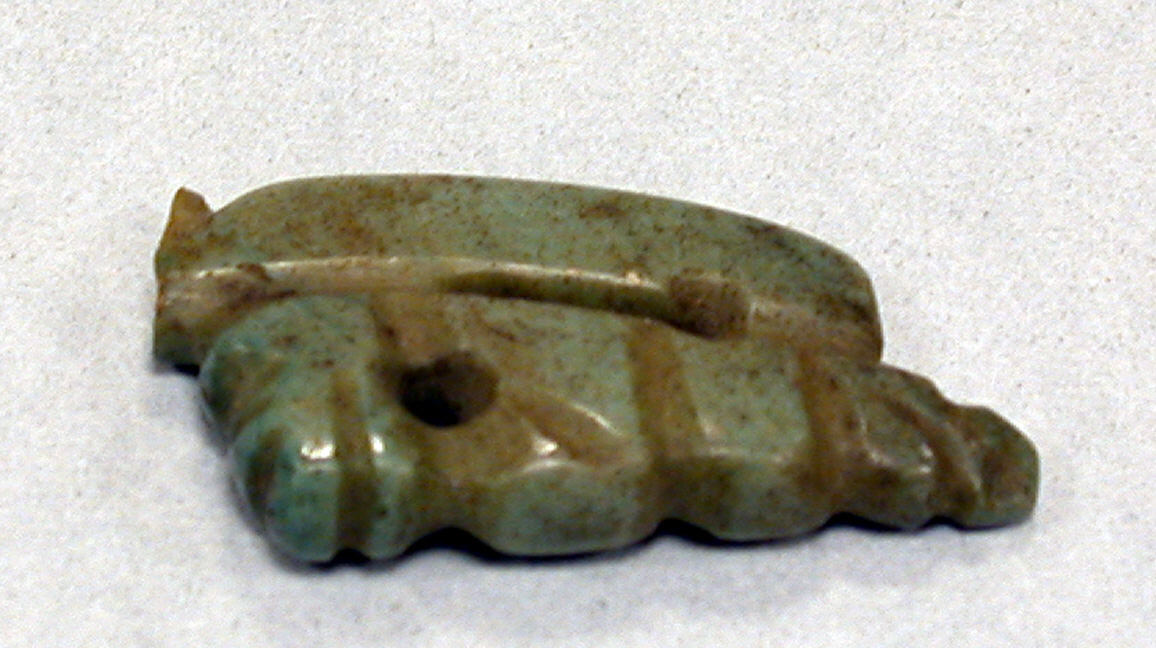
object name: pendant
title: Stone Animal Pendant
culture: costa rican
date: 801-1500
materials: stone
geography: costa rica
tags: animals